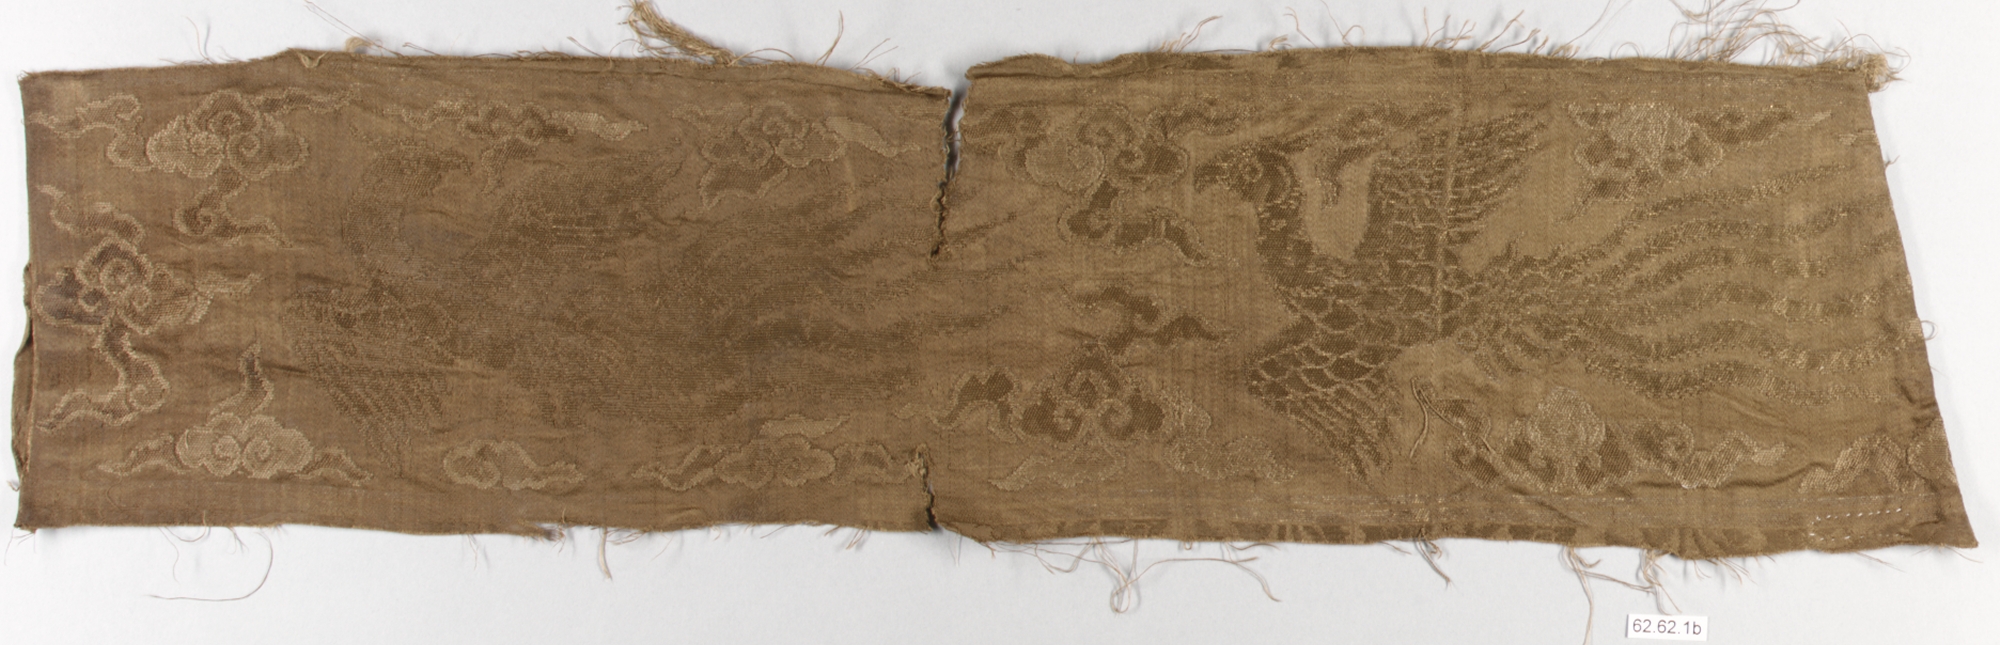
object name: robe front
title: Fragments of Robe-Front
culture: chinese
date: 1601-1650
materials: silk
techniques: gilding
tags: pheasants